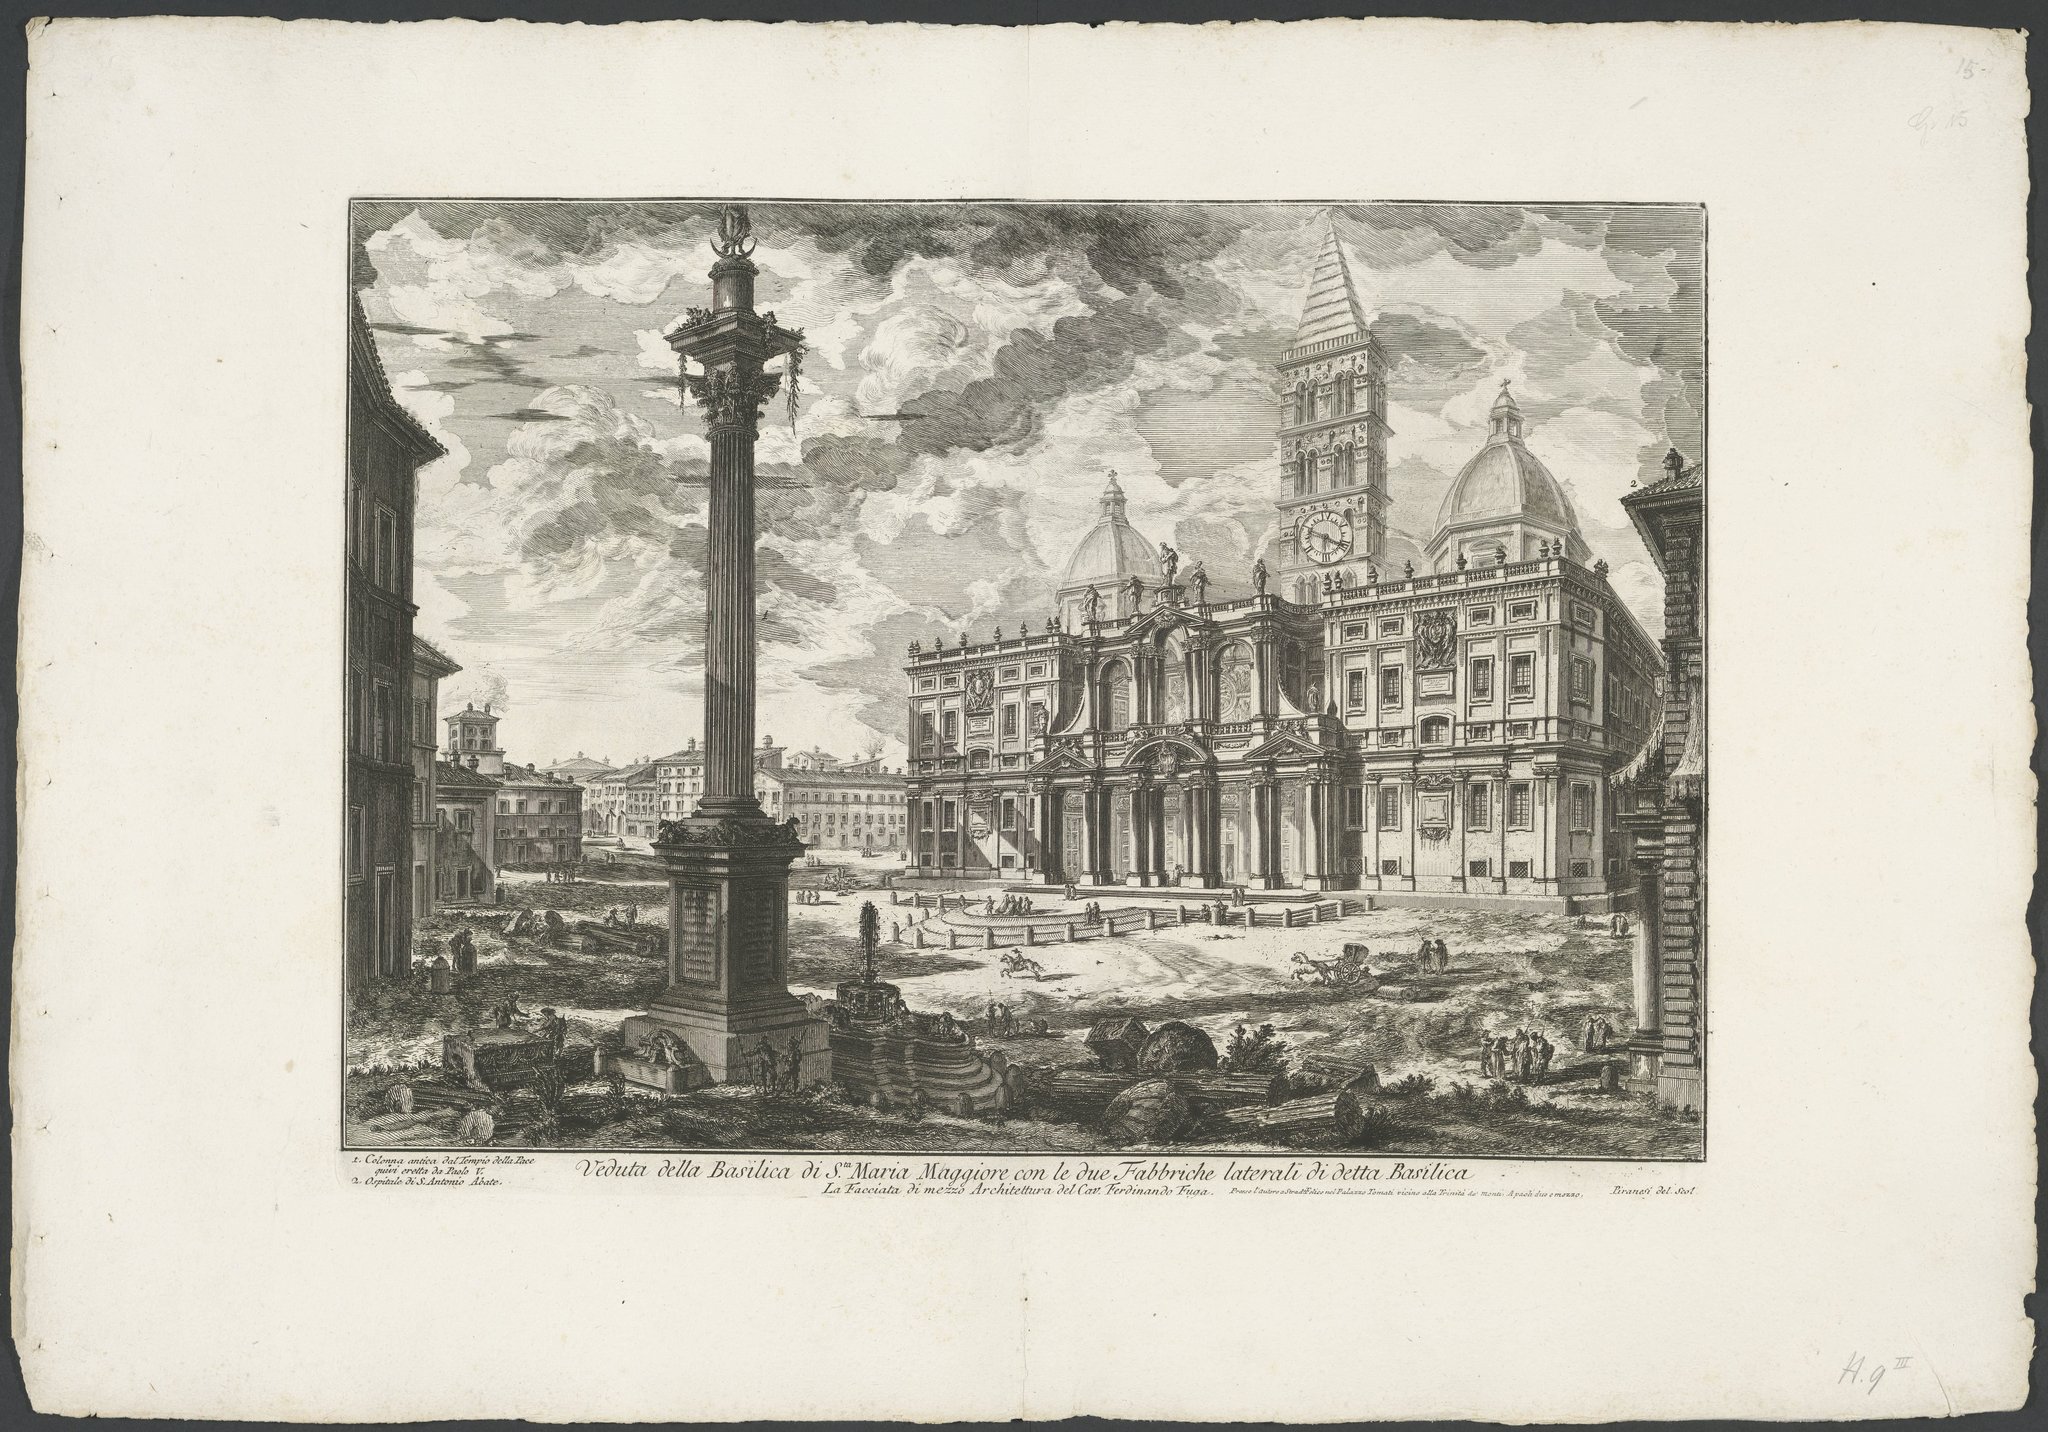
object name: print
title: Veduta della Basilica di S.ta Maria Maggiore con le due Fabbriche laterali di detta Basilica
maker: giovanni battista piranesi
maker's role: designer, draughtsman, print maker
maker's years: 1720-1778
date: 1748-1778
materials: paper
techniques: etching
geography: rome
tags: column, pillar ~ architecture, church (exterior), roman catholic church, rome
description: Deze prent maakt deel uit van de serie 'Vedute di Roma'. Piranesi werkte aan deze 135 platen tellende serie tussen 1748 en zijn dood in 1778. Francesco Piranesi voegde later nog twee prenten toe aan de reeks van zijn vader.